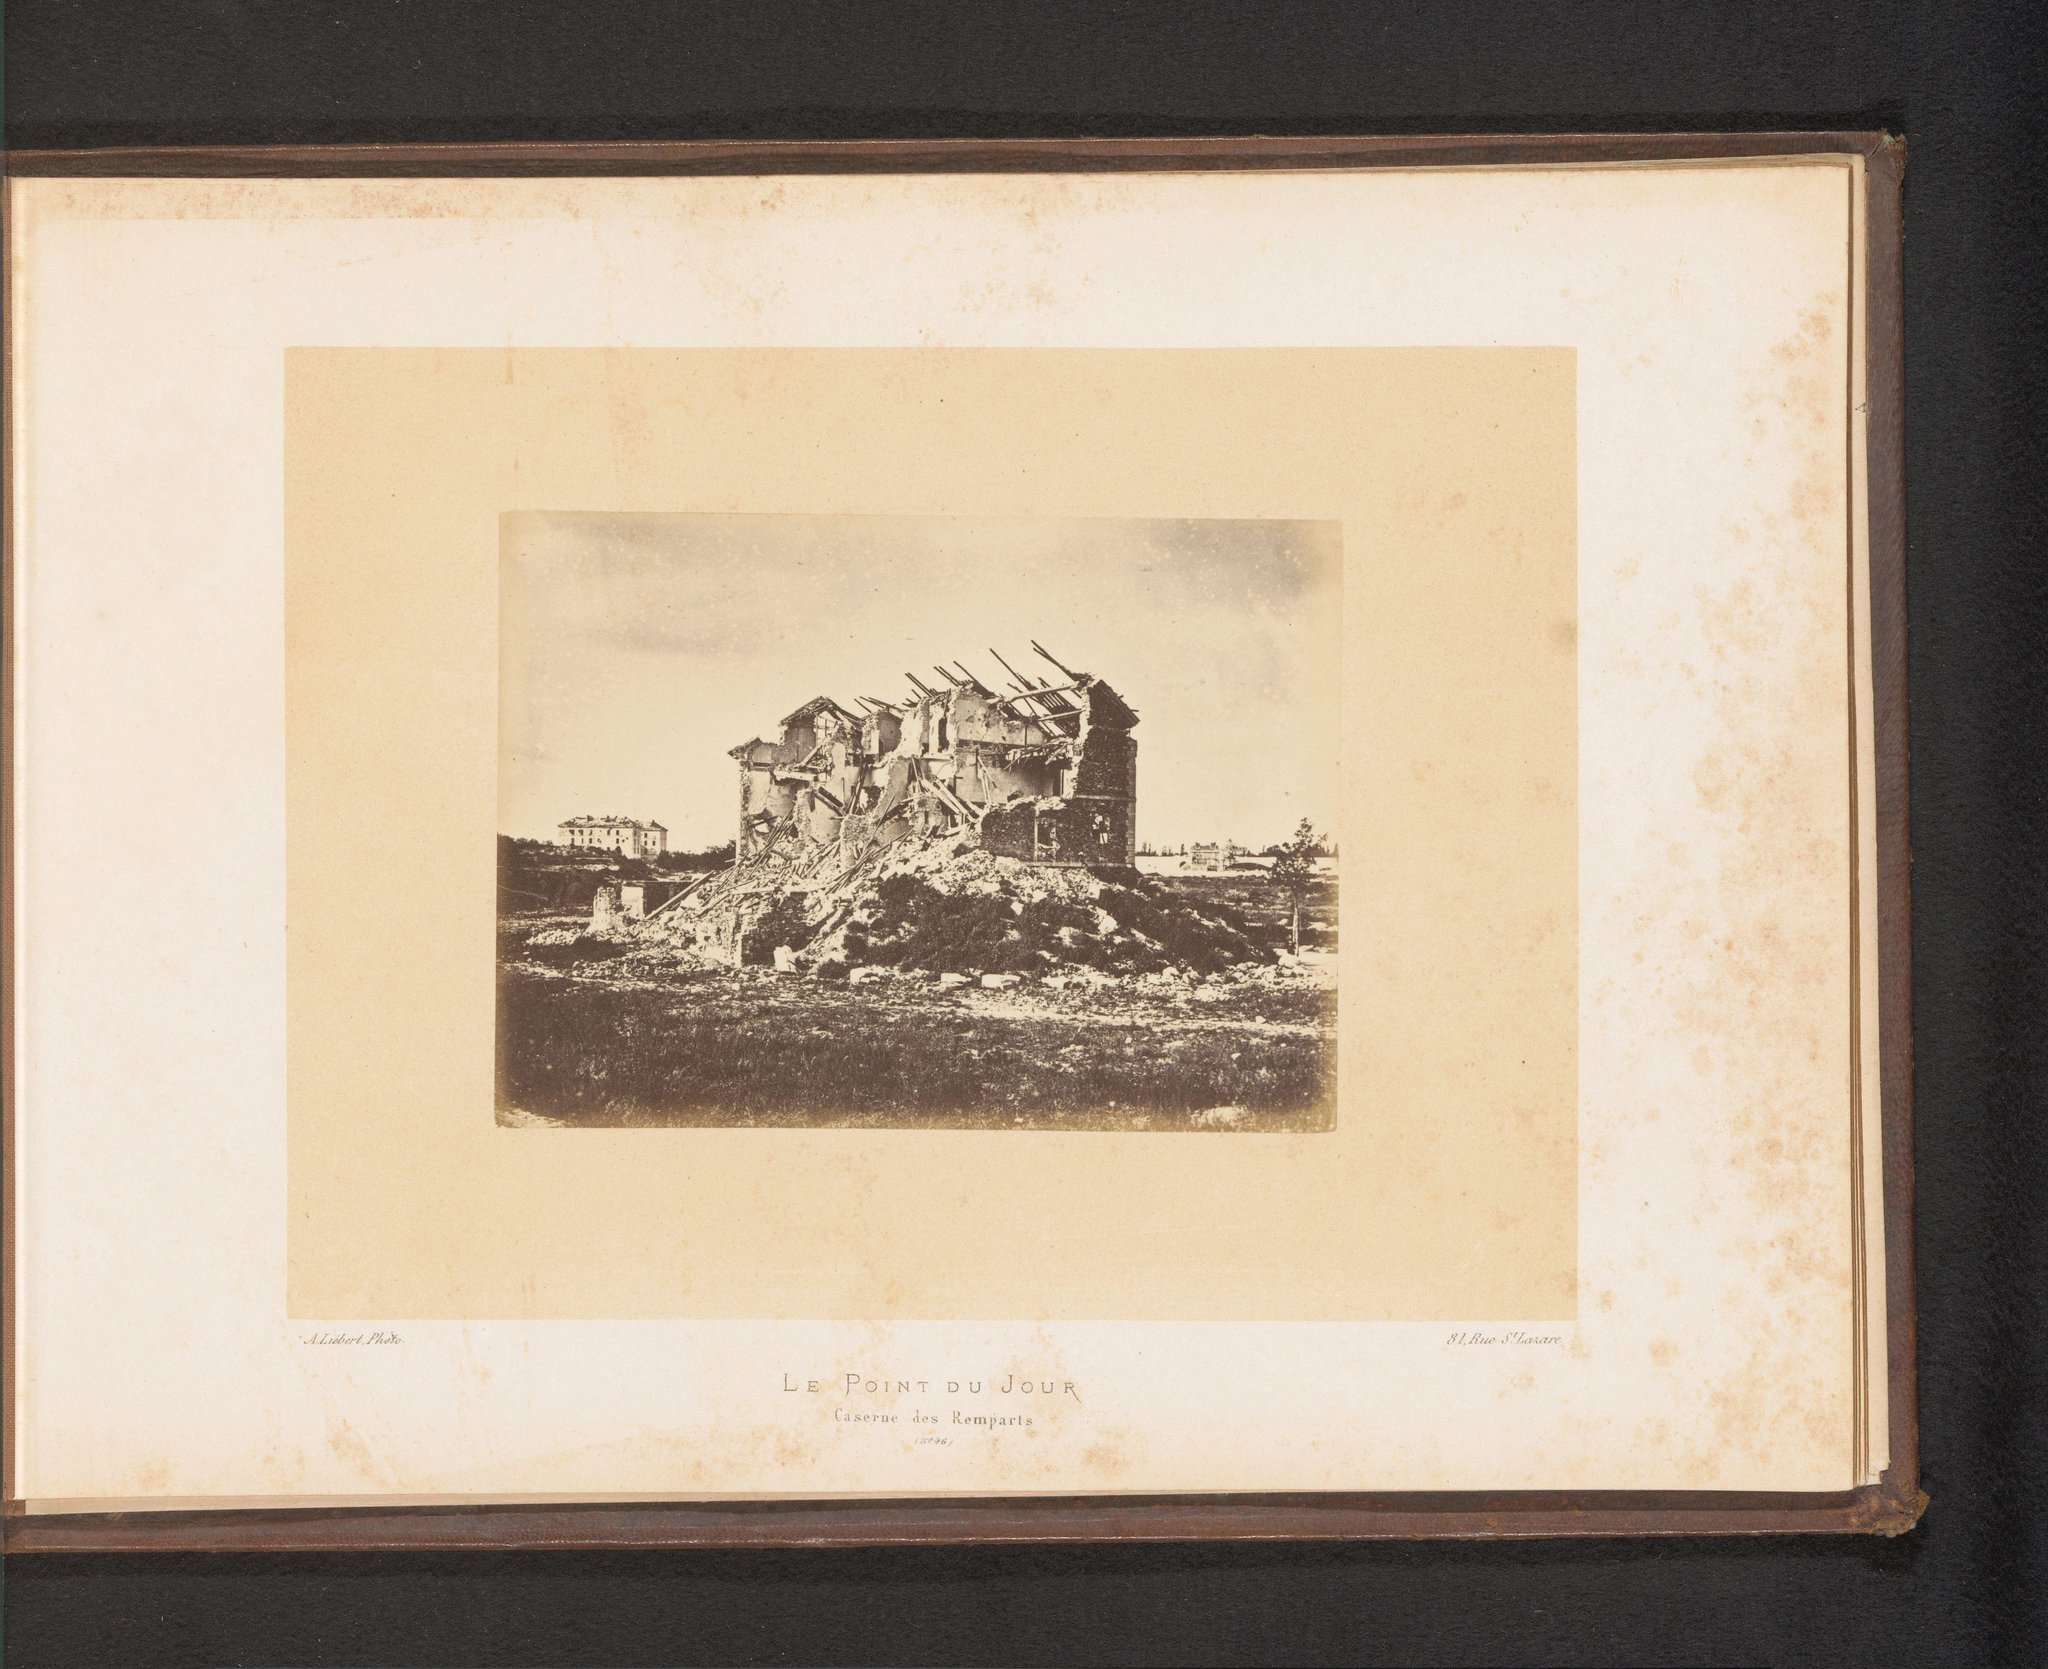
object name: photograph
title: Gezicht op een barak bij Point du Jour in Parijs na de brand door de Commune van Parijs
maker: alphonse-justin liébert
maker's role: fotograaf, marinier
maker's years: 1827-1914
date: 1871-1872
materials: photographic support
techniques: albumen print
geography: paris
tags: ruin of a building ~ architecture, barracks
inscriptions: number: ‘(No. 46)’, address: ‘31, Rue St. Lazare’